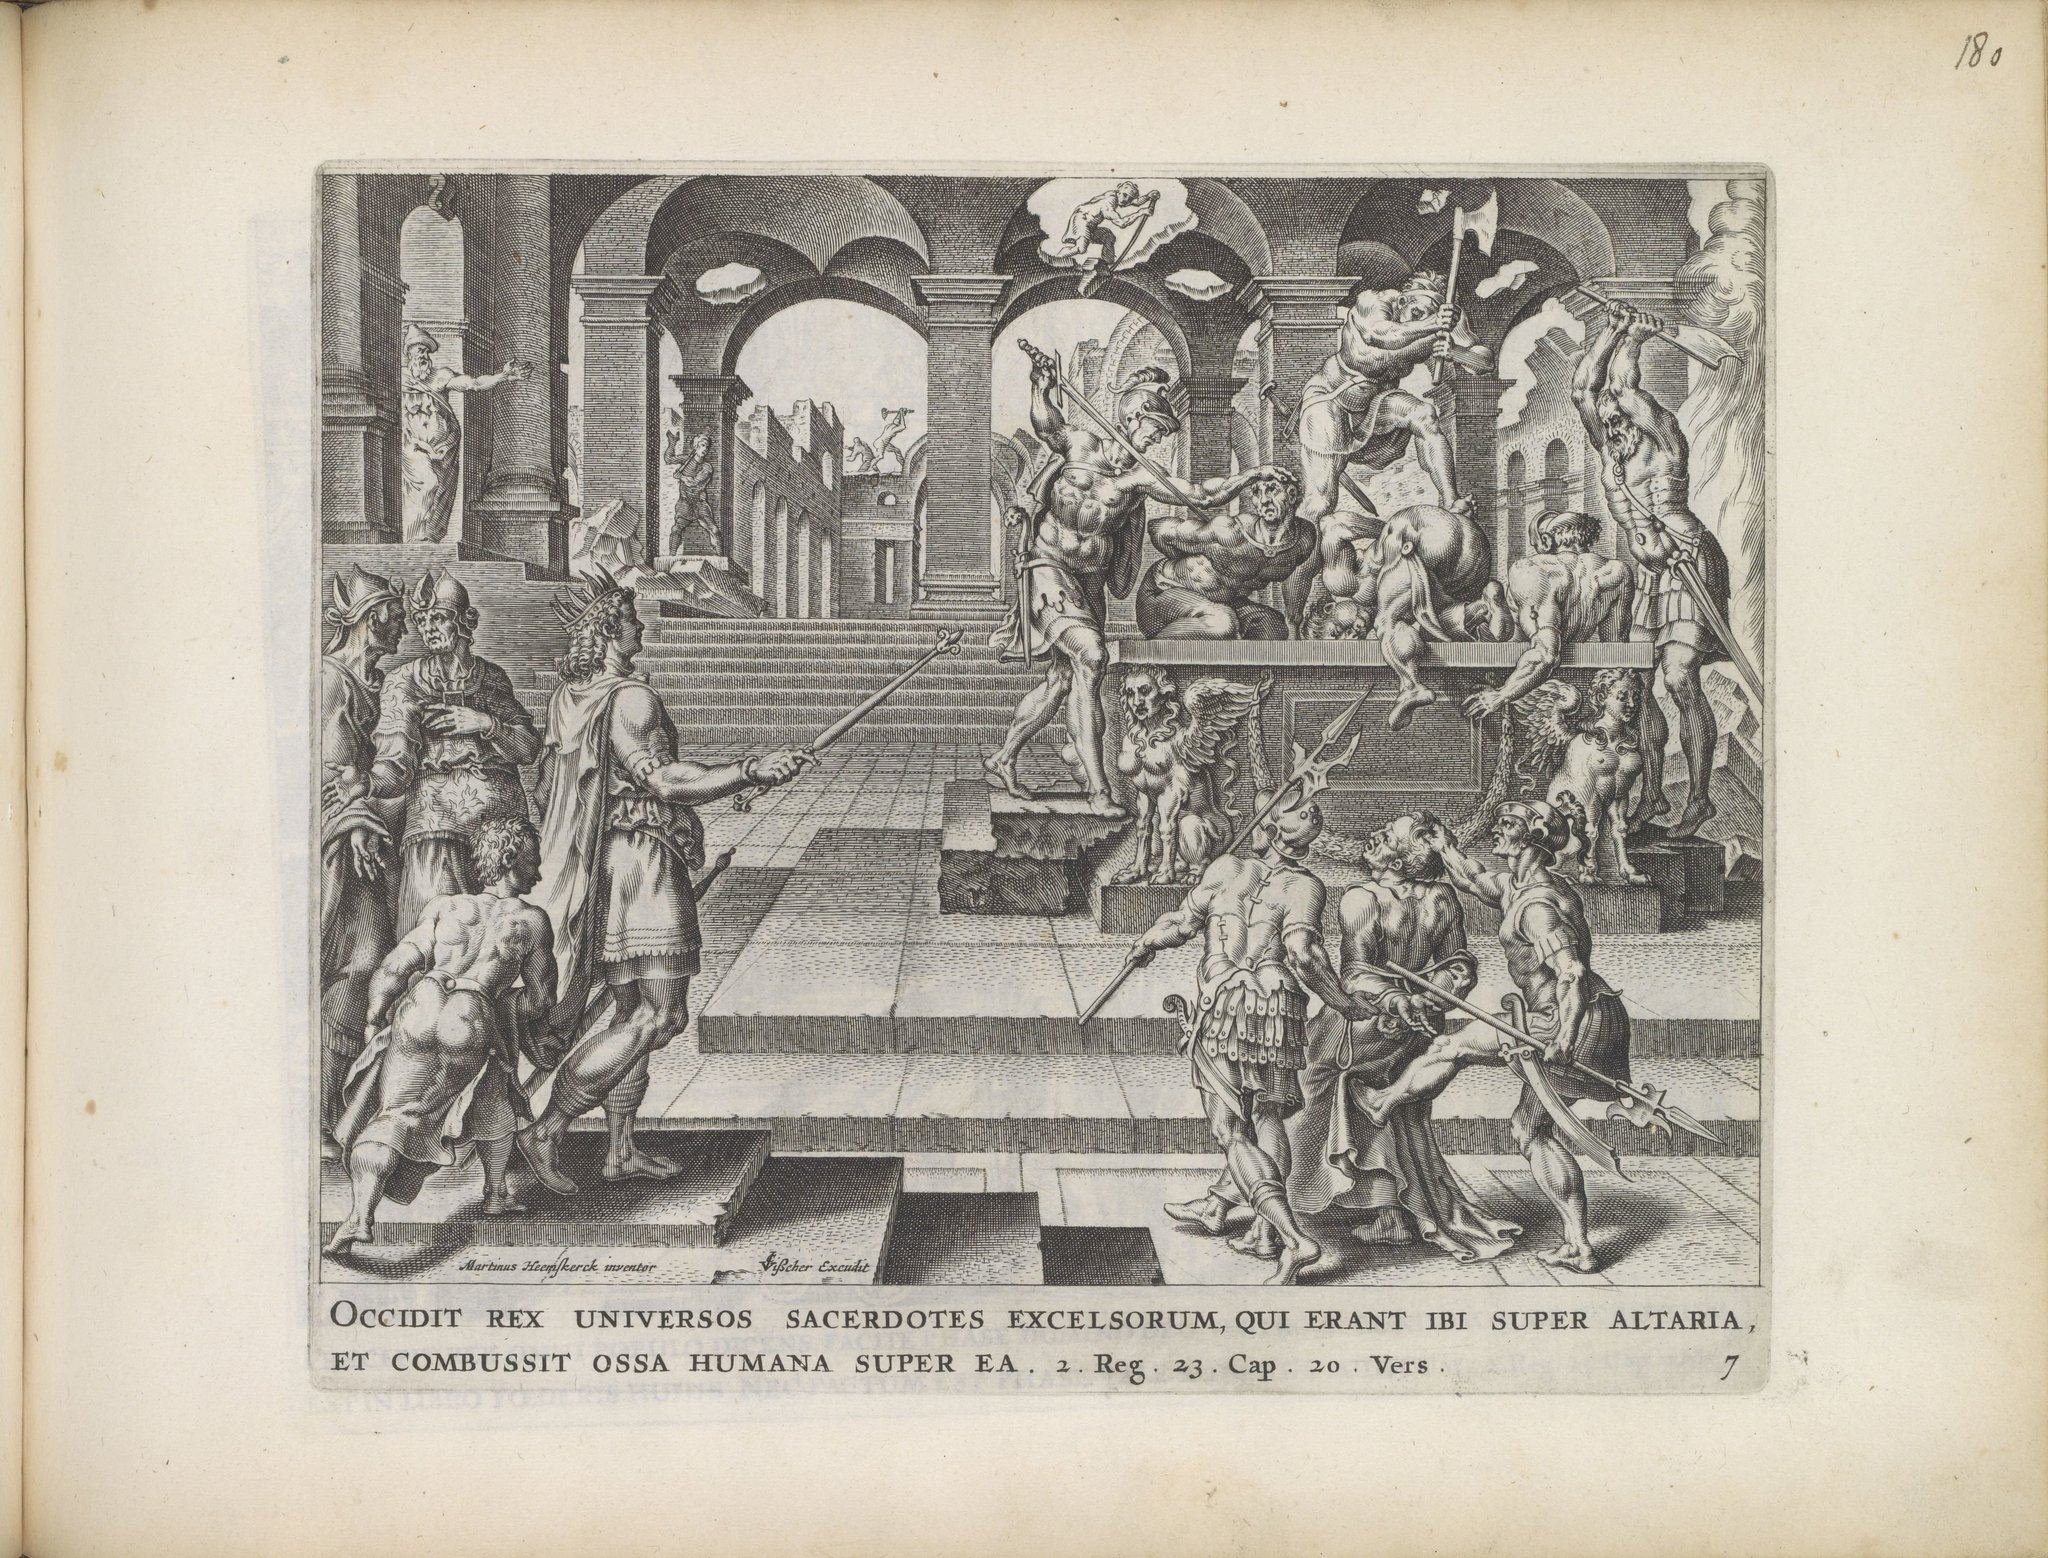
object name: print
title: Koning Josia geeft opdracht de priesters van de tempels in Samaria te vermoorden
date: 1643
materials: paper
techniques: engraving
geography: amsterdam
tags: the pagan priests are either killed or suppressed ~ story of josiah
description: Koning Josia staat in de tempel van Samaria en laat de priesters op de offeraltaren vermoorden. Soldaten van Josia slaan de priesters met bijlen en zwaarden. Onder de voorstelling een verwijzing in het Latijn naar de Bijbeltekst in 2 Kon. 23:20. Deze prent maakt deel uit van een album.